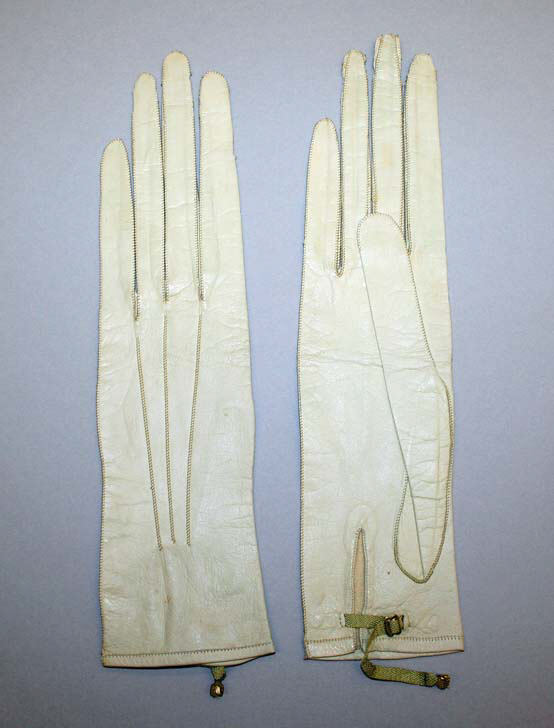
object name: glove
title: Gloves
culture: french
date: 1885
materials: leather